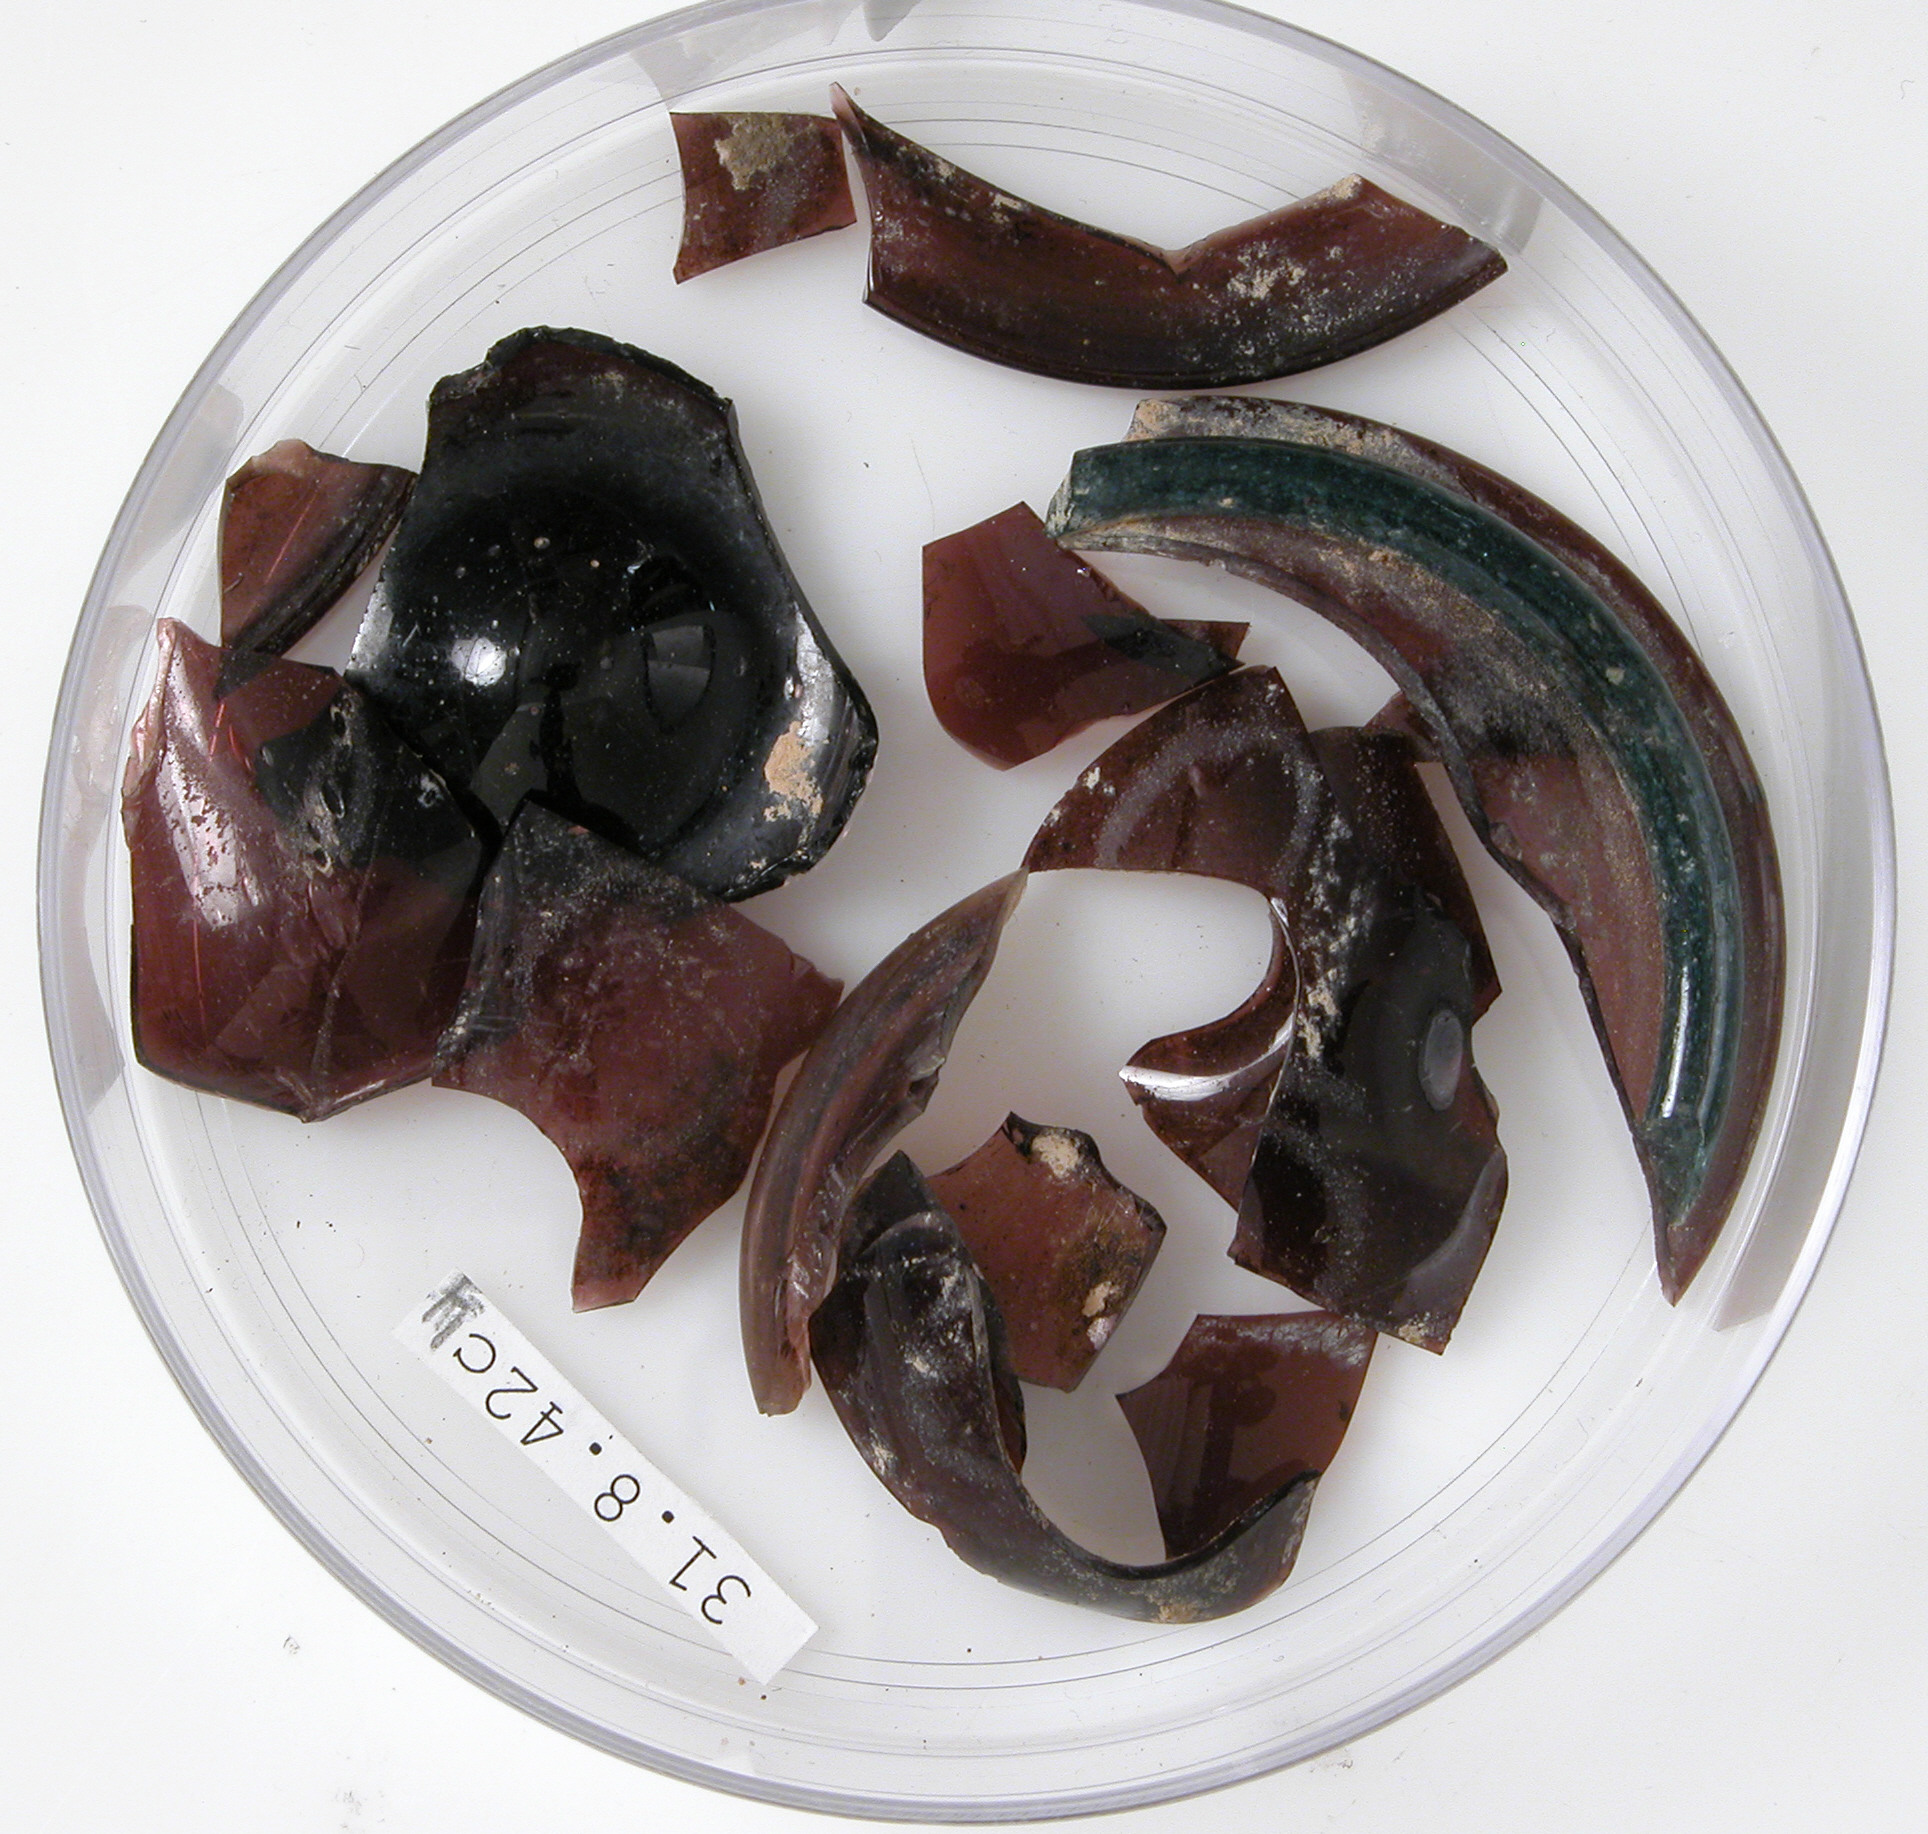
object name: fragment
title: Glass Fragments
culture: coptic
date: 301-400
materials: glass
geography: egypt